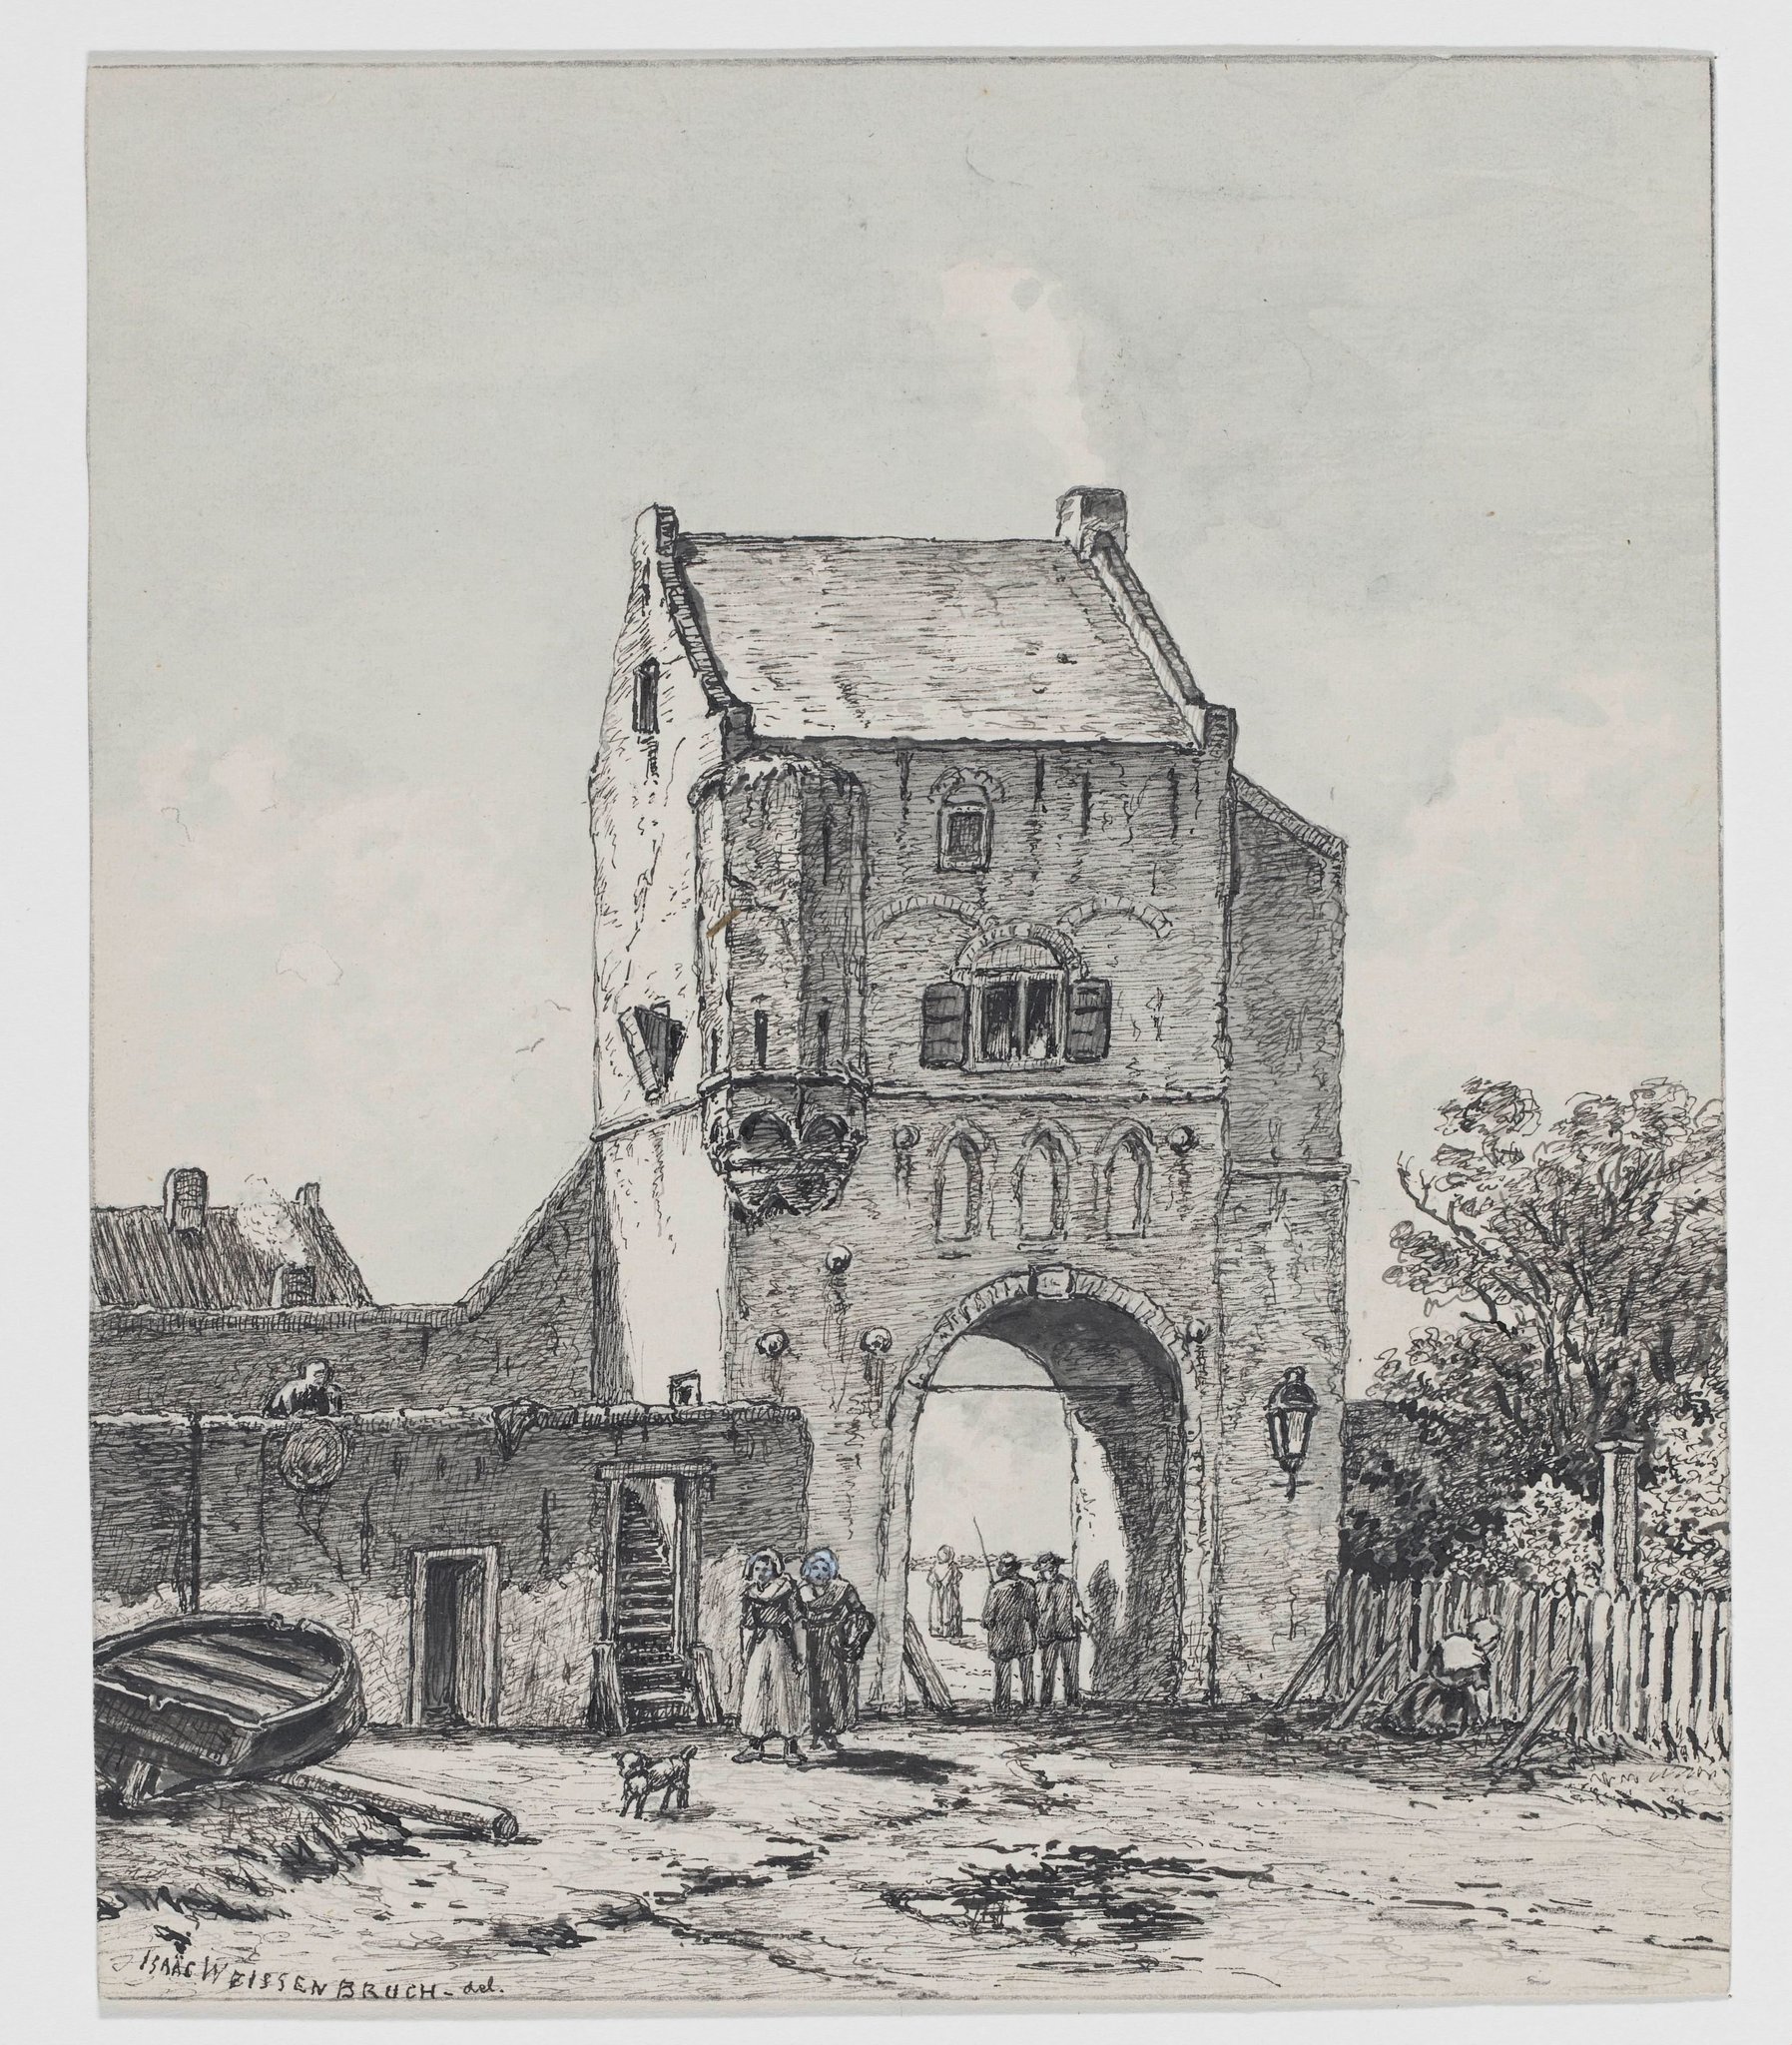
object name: drawing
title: Water- of Gevangenpoort te Woudrichem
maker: isaac weissenbruch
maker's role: print maker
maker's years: 1826-1912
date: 1836-1912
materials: ink, paper, pencil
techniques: brush, pen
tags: city-gate, woudrichem